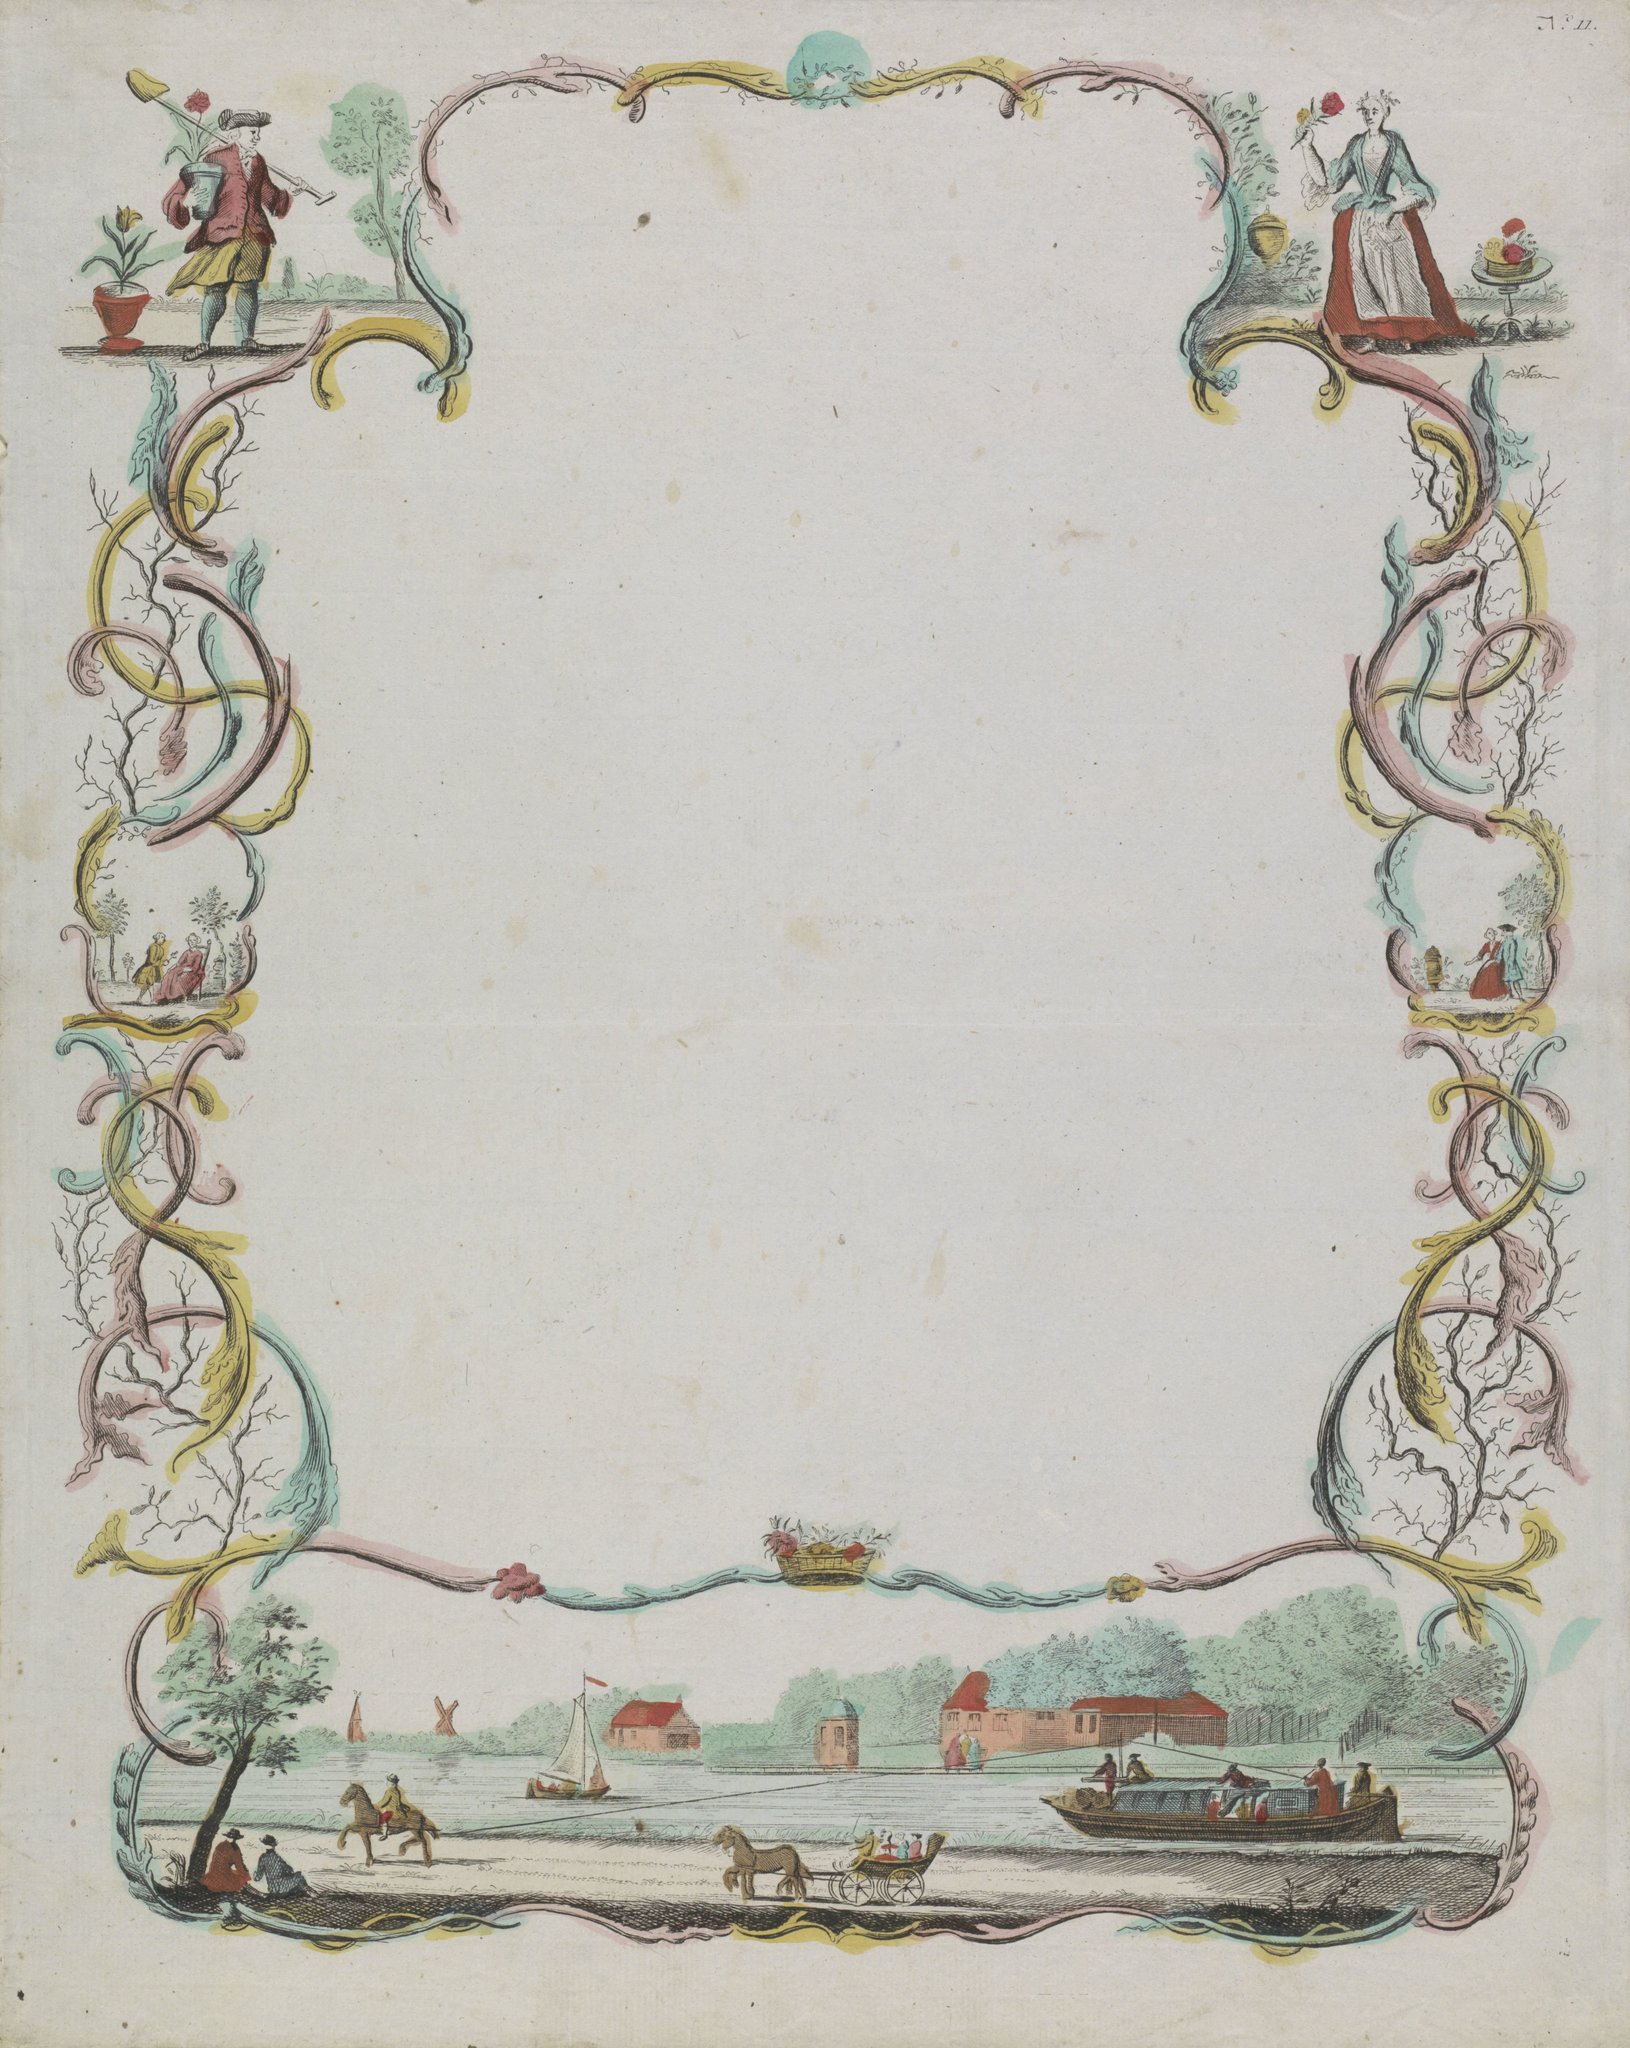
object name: wensbrief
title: Wensbrief met trekschuit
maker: Anonymous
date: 1784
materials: ink, paper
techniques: calligraphy, colour, etching, pen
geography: netherlands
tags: plants; vegetation, tow-boat, towing-barge, foliage, tendrils, branches ~ ornament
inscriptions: collector's mark: Lugt 2760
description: Wensbrief met onbeschreven cartouche binnen een decoratief kader met voorstellingen van een man met planten, een vrouw met bloemen en van een trekschuit. Genummerd rechtsboven: No. 11.